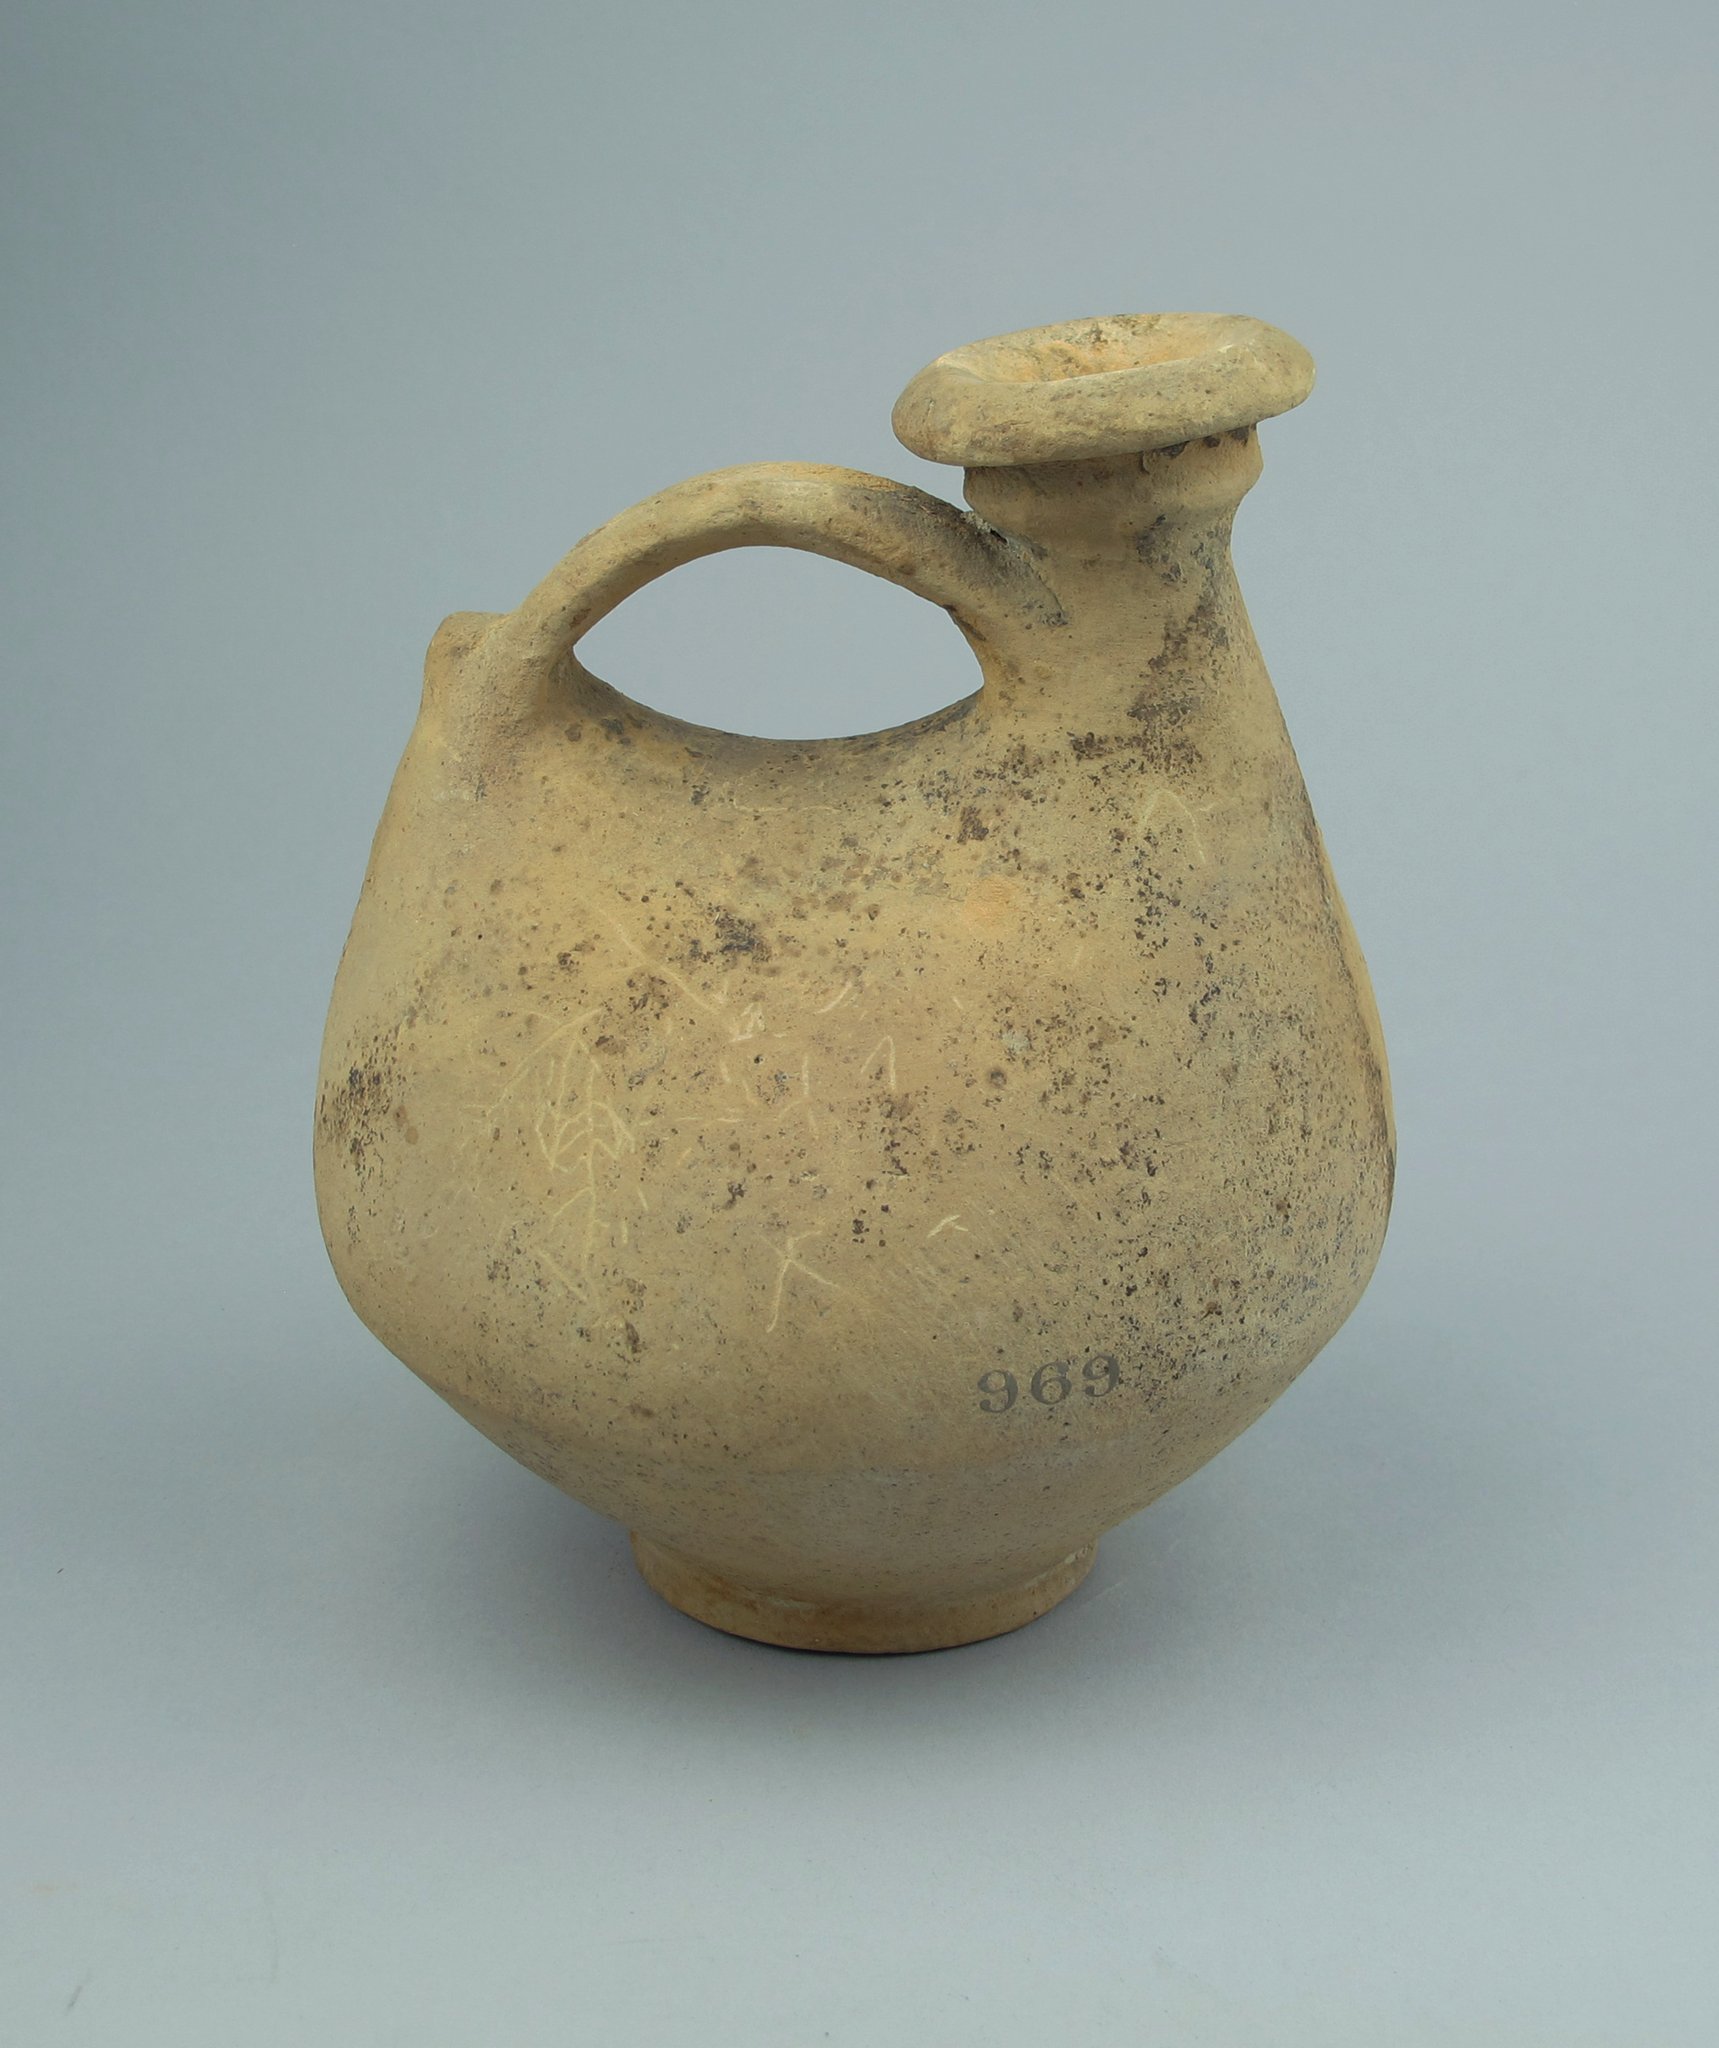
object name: askos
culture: cypriot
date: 600-480 BCE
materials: terracotta